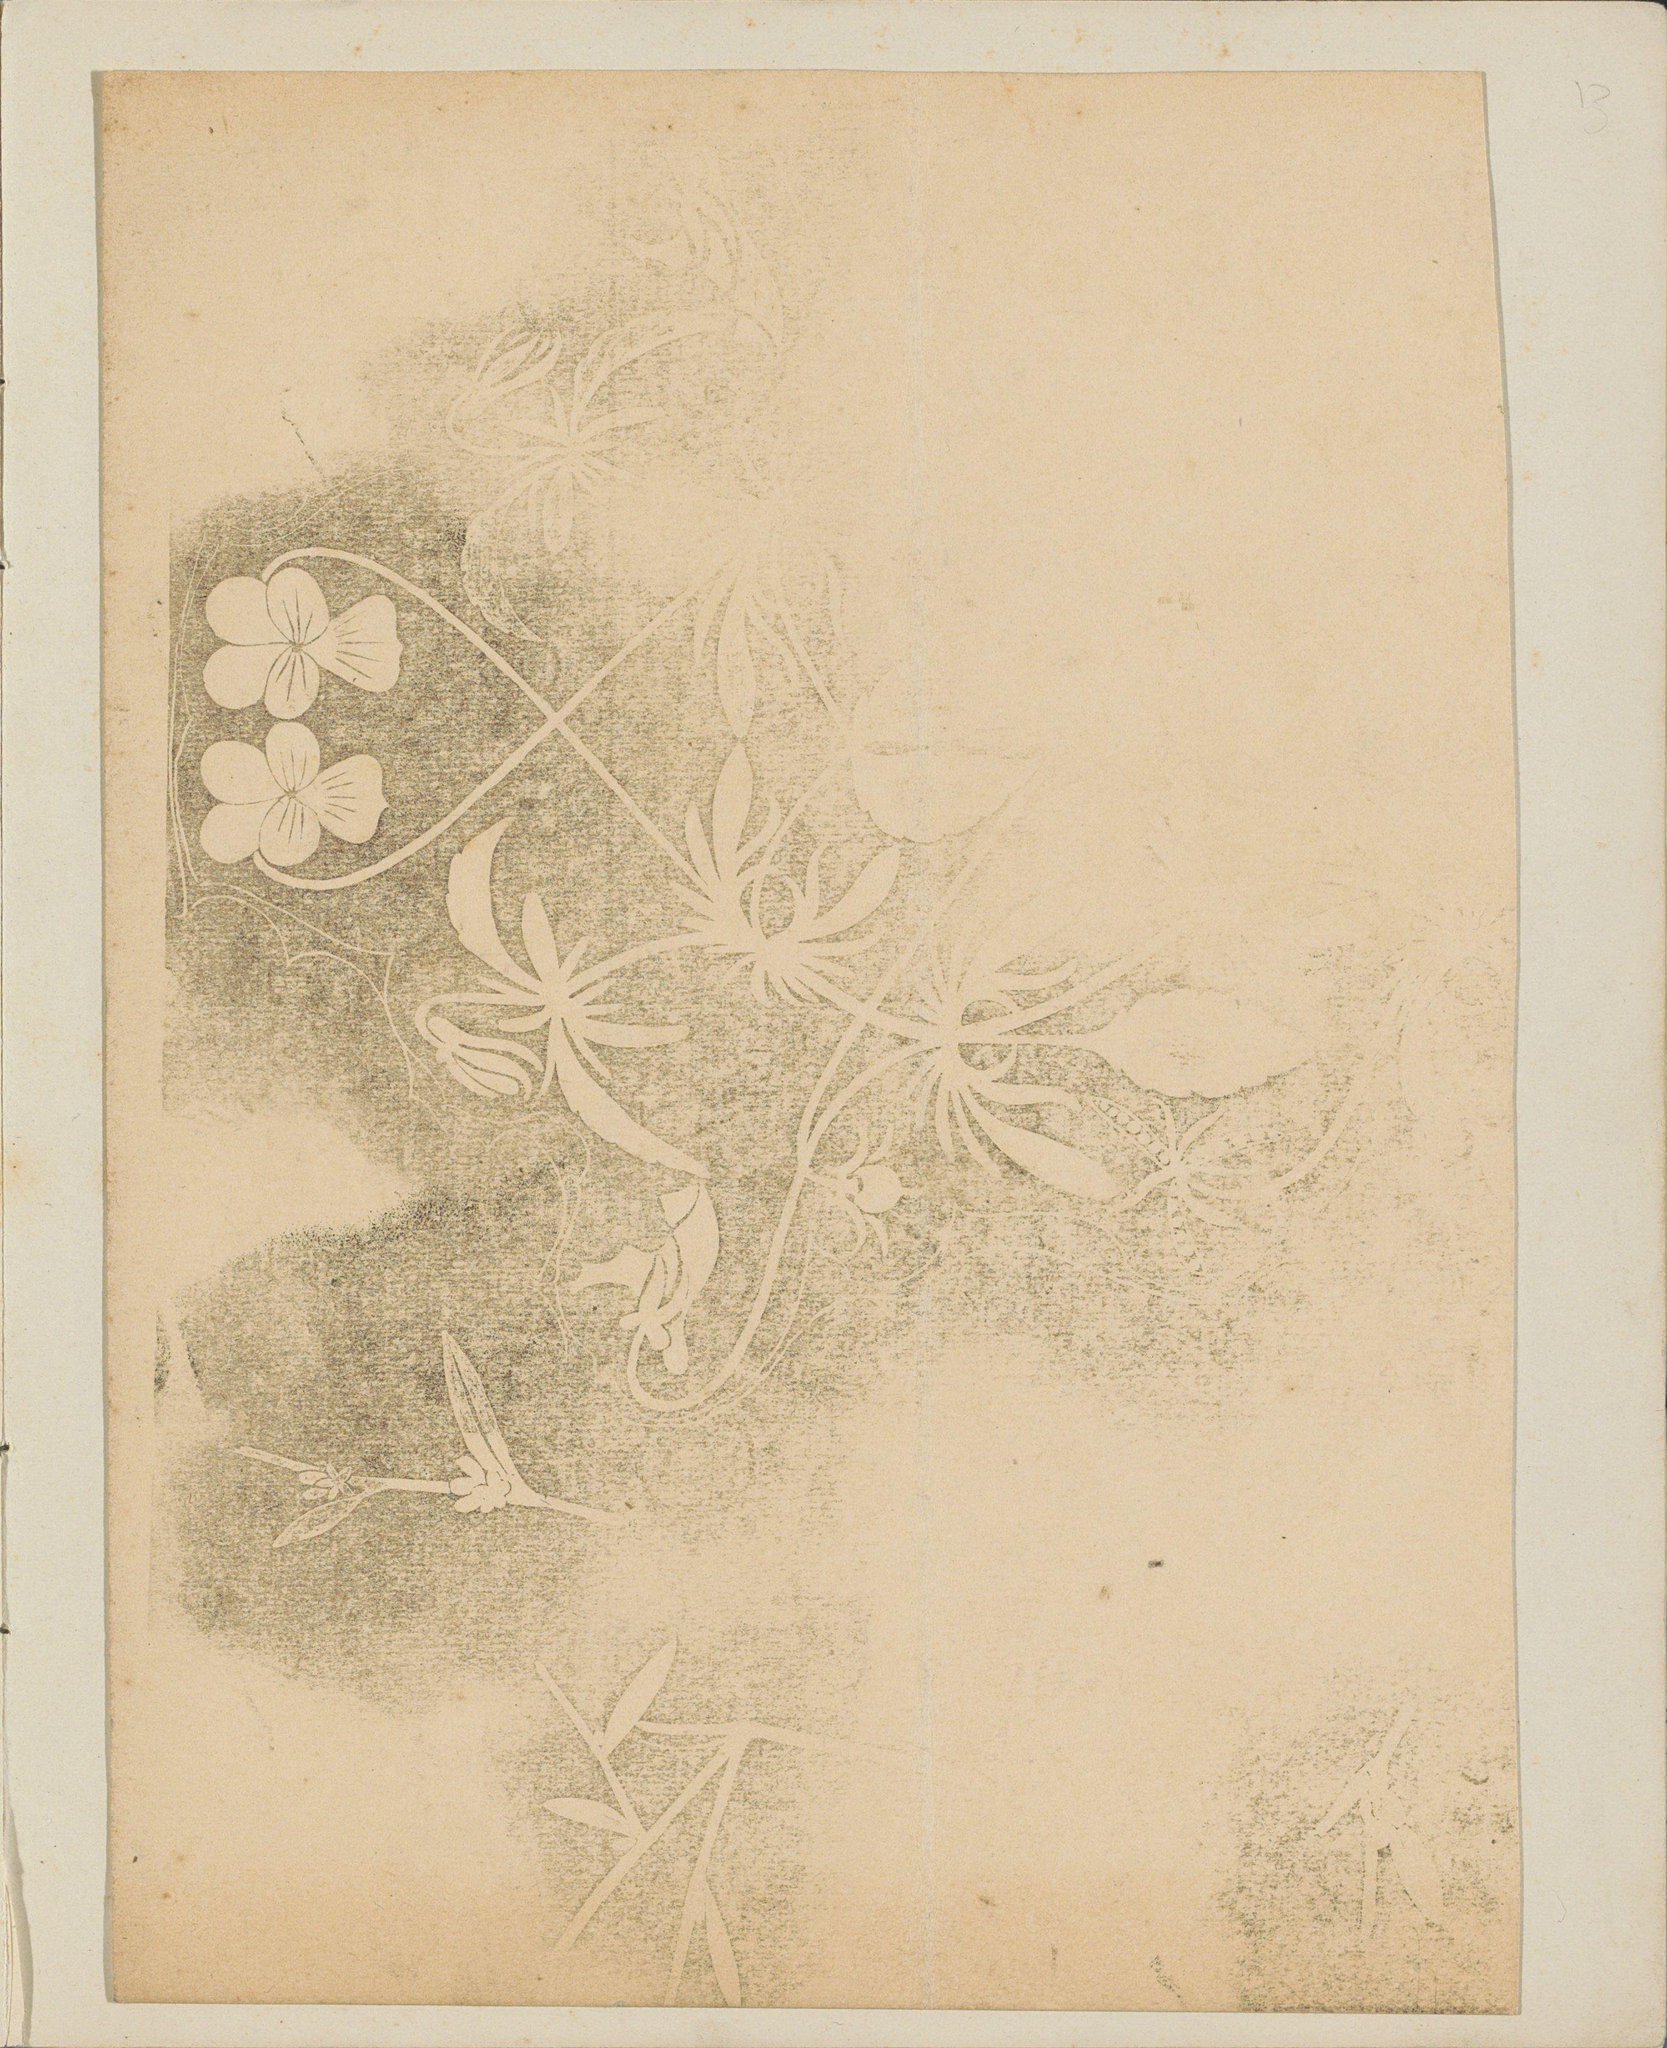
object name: album leaf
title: Ornament met bladeren en bloemen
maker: gerrit willem dijsselhof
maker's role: designer, draughtsman, print maker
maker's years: 1866-1924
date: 1874-1924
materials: paper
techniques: woodcut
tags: foliage, tendrils, branches ~ ornament, flowers ~ ornament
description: Blad 13 recto uit een album met 17 bladen.